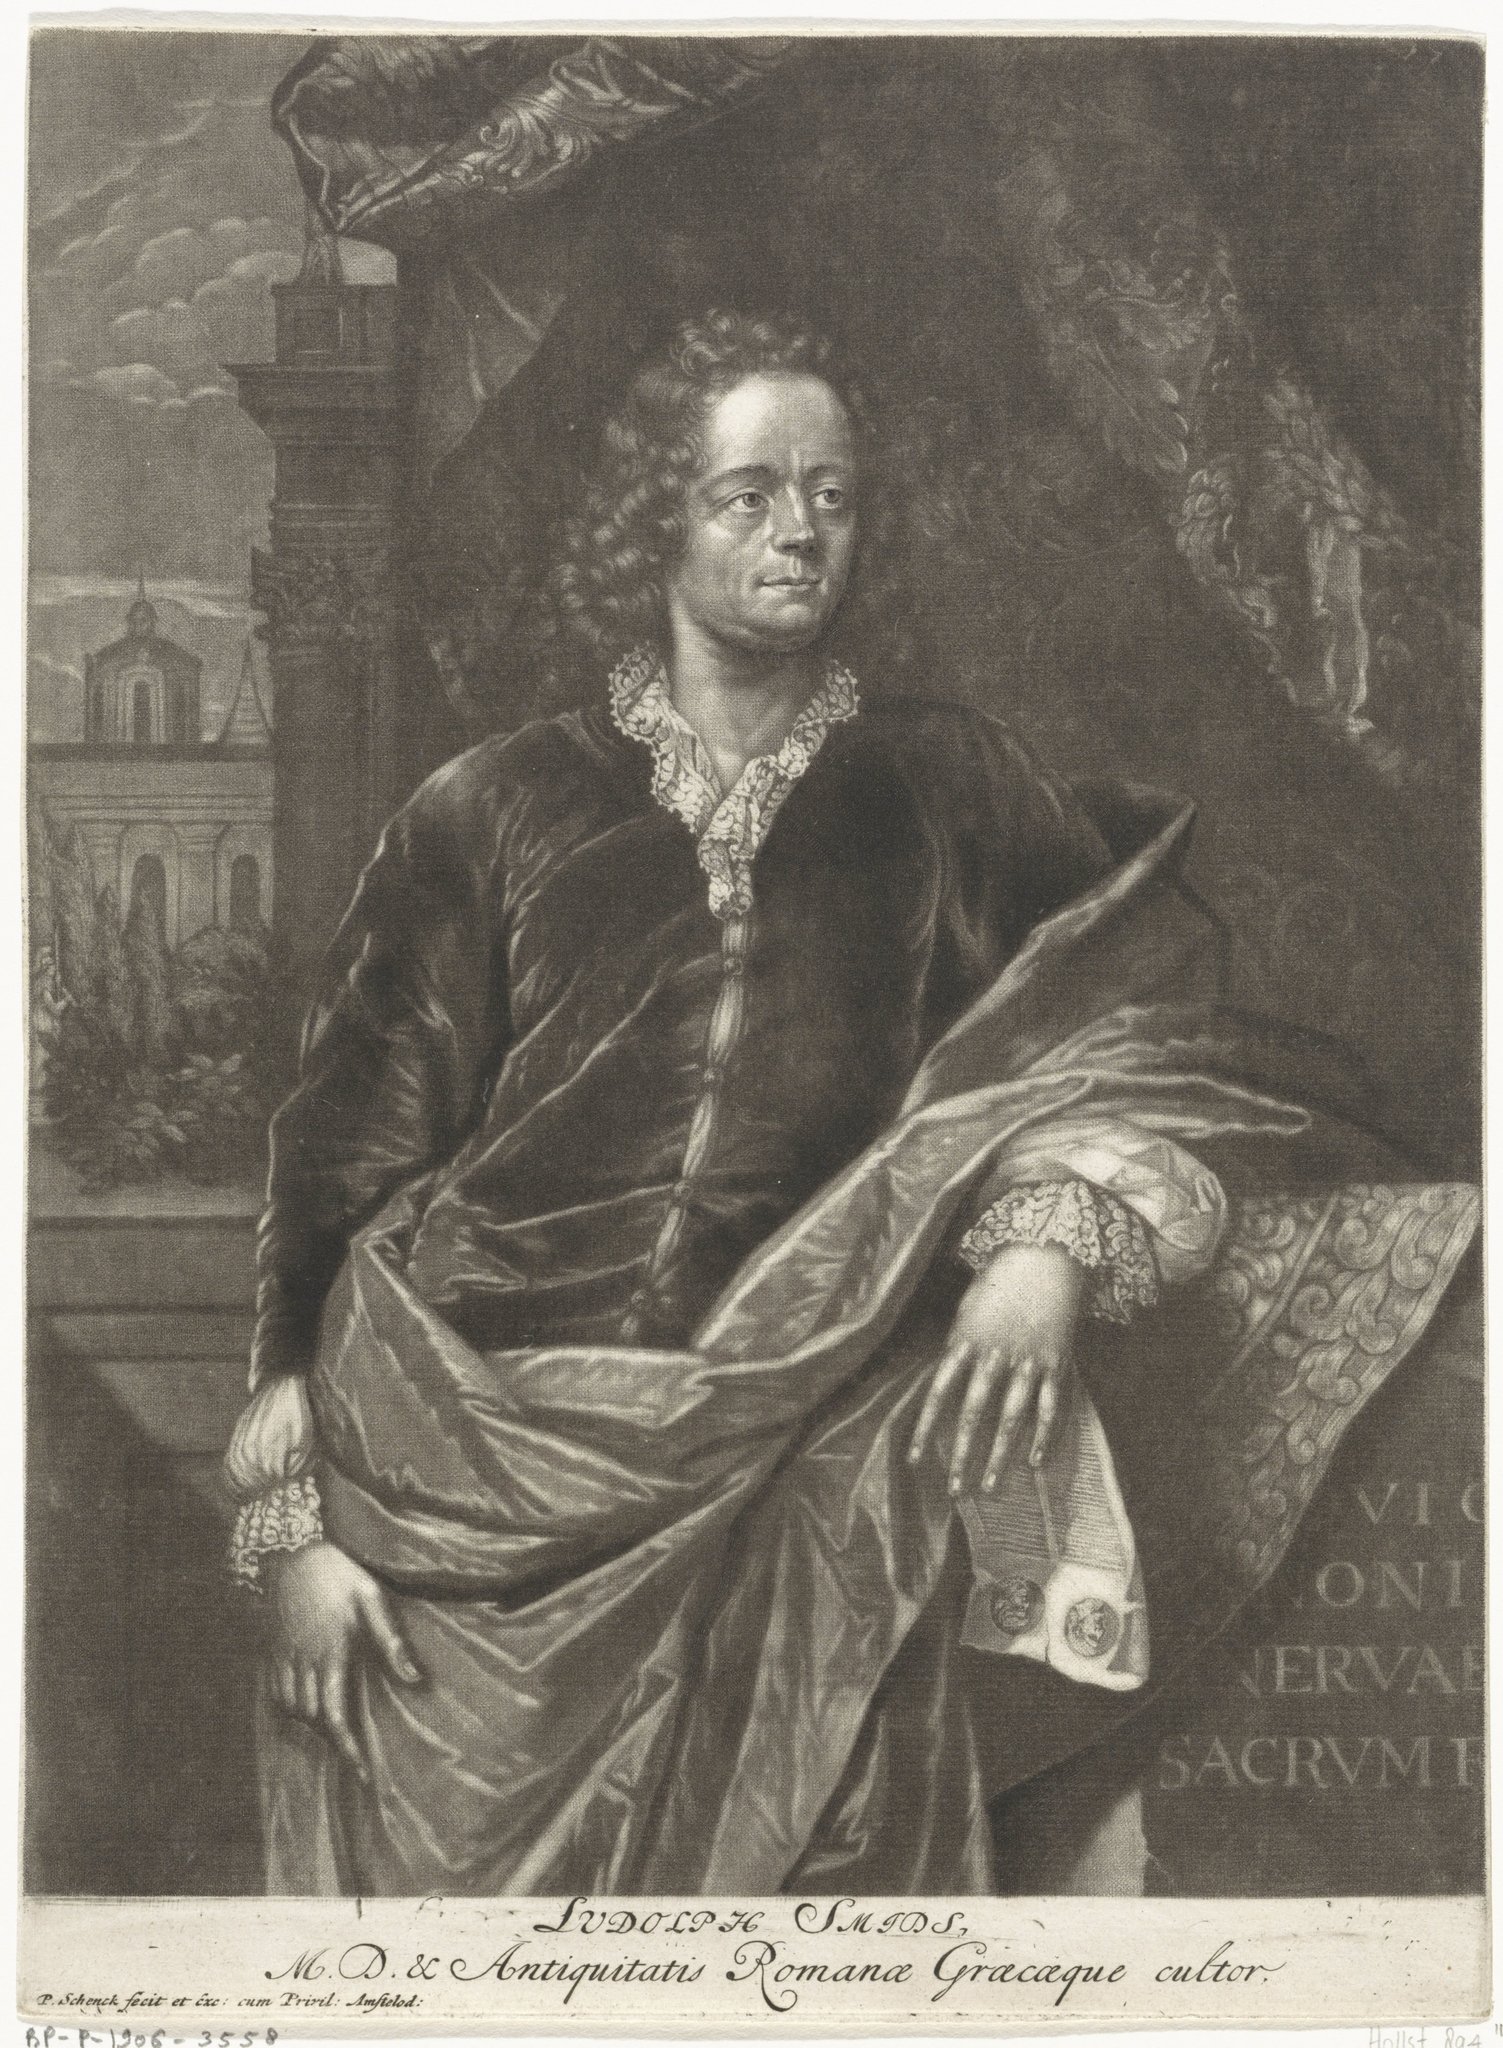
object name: print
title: Portret van Ludolph Smids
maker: pieter schenk (i)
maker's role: print maker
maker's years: 1660-1711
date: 1670-1713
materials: paper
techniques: engraving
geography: amsterdam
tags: amsterdam, ludolph smids, letter, envelope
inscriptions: collector's mark: Lugt 2228, collector's mark: Lugt 567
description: De dichter, oudheidkundige en arts Ludolph Smids met in zijn hand een brief waarop twee medaillons waarin klassieke bustes. Achter hem een draperie en een gebouw.